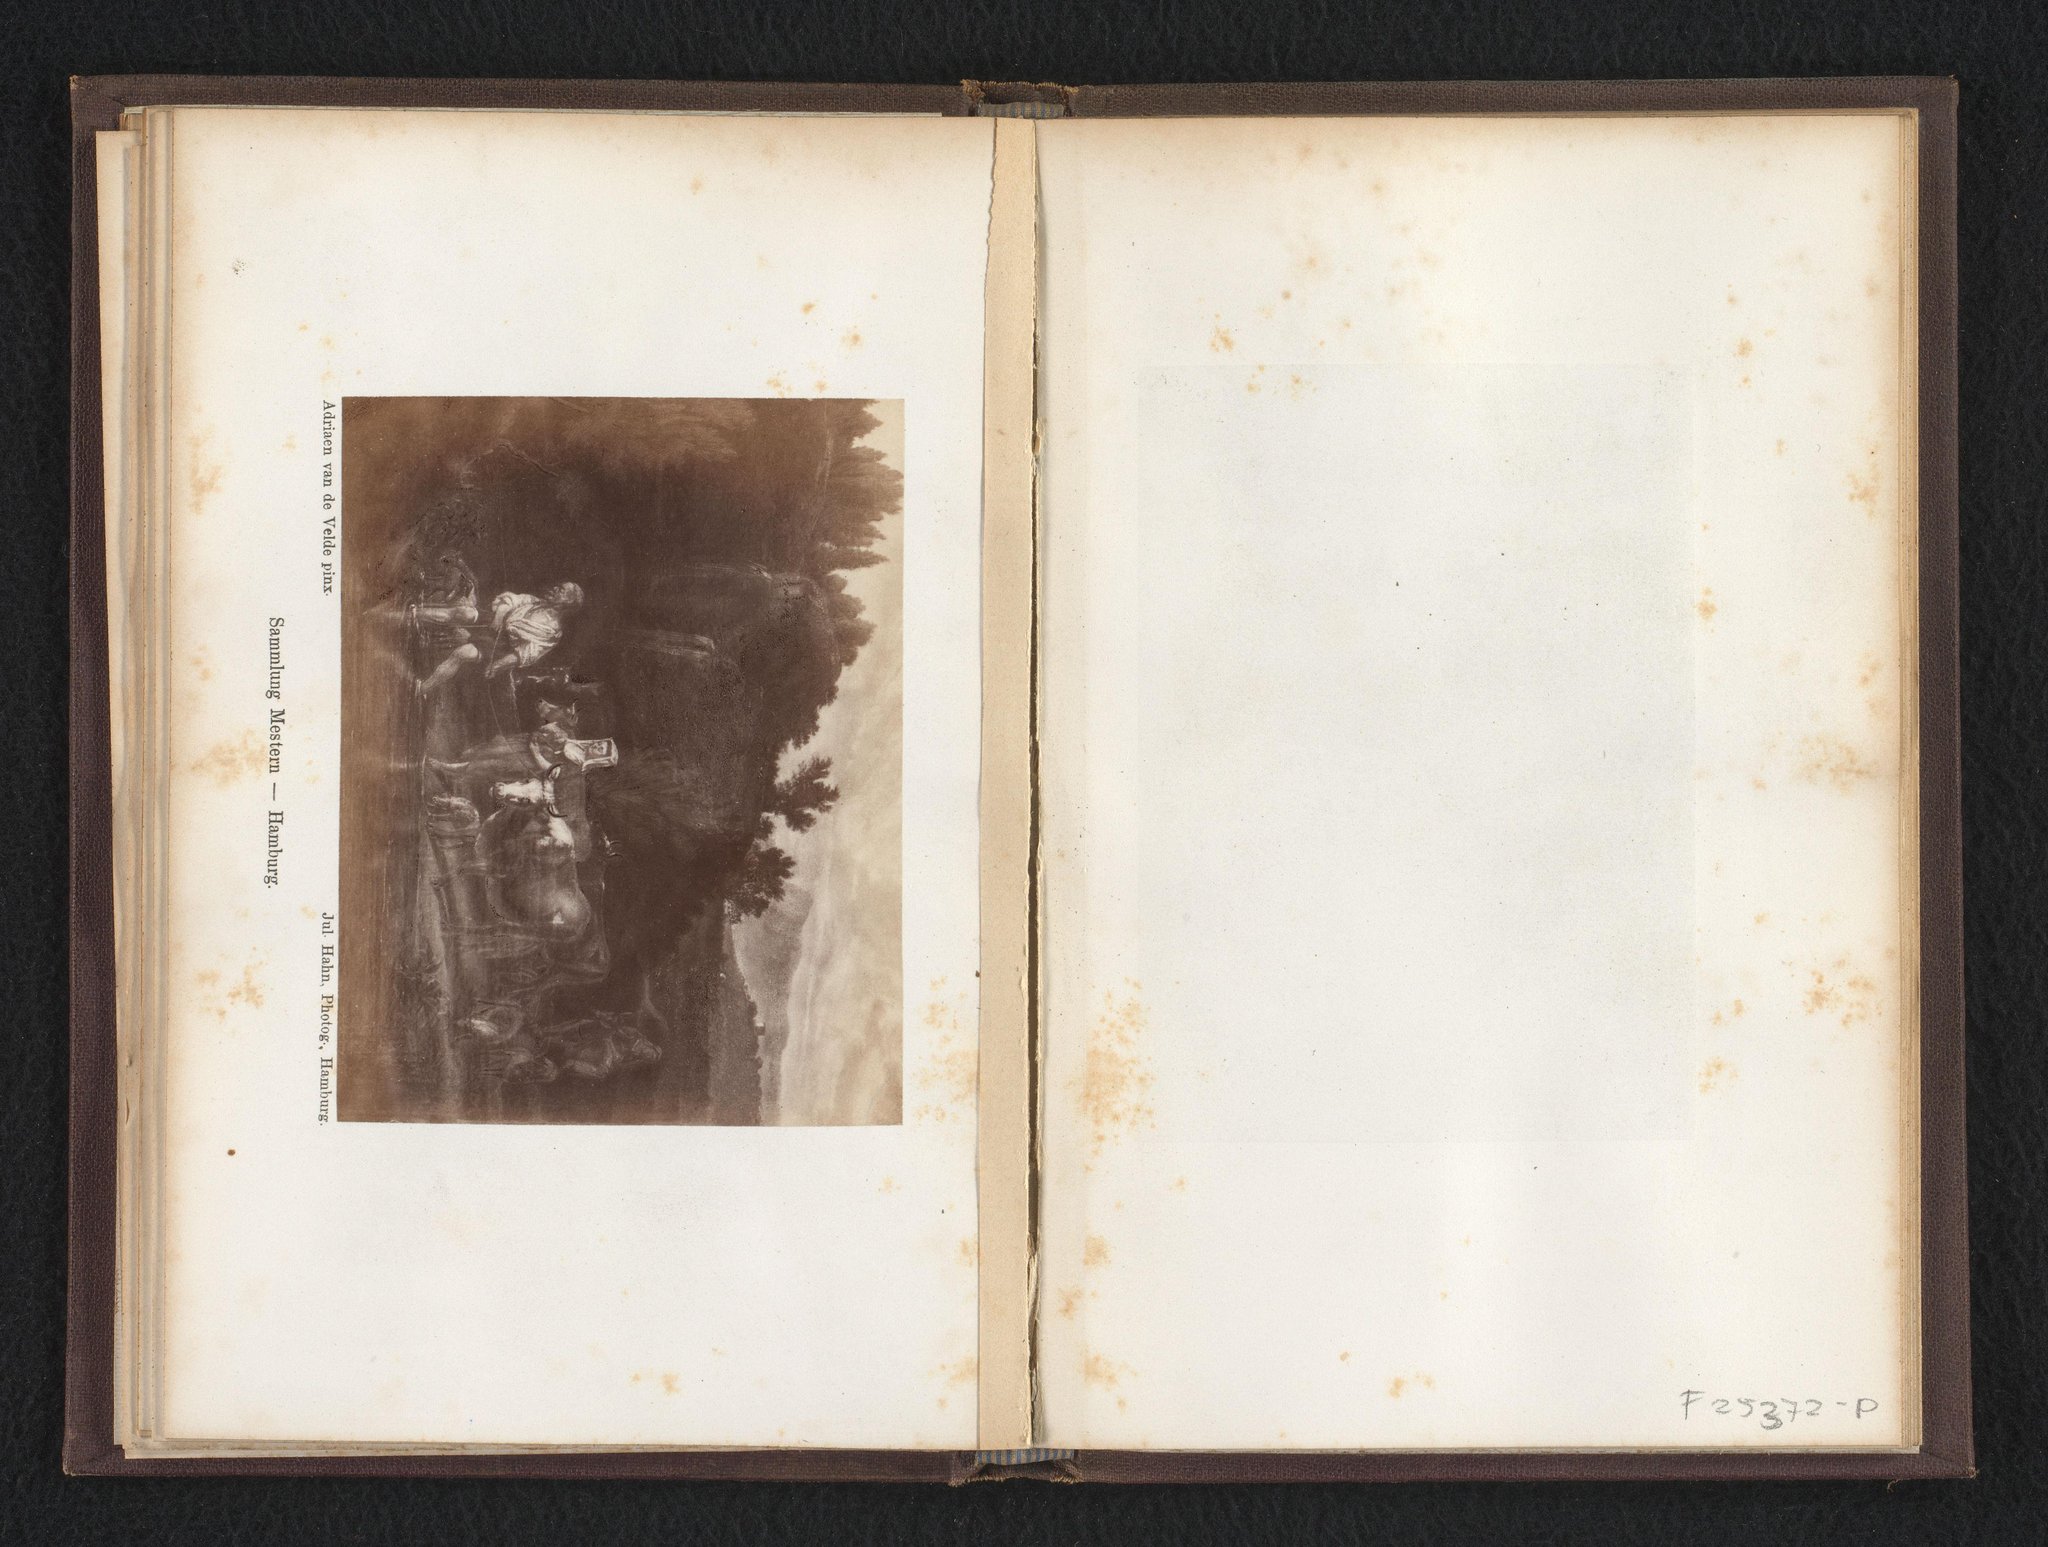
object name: reproduction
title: Fotoreproductie van een schilderij van vee dat door een rivier waadt door Adriaen van de Velde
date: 1864-1874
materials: paper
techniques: albumen print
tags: picture, painting, bovine cattle, wading, paddling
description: Foto op vierde ongenummerde pagina na pagina 18.